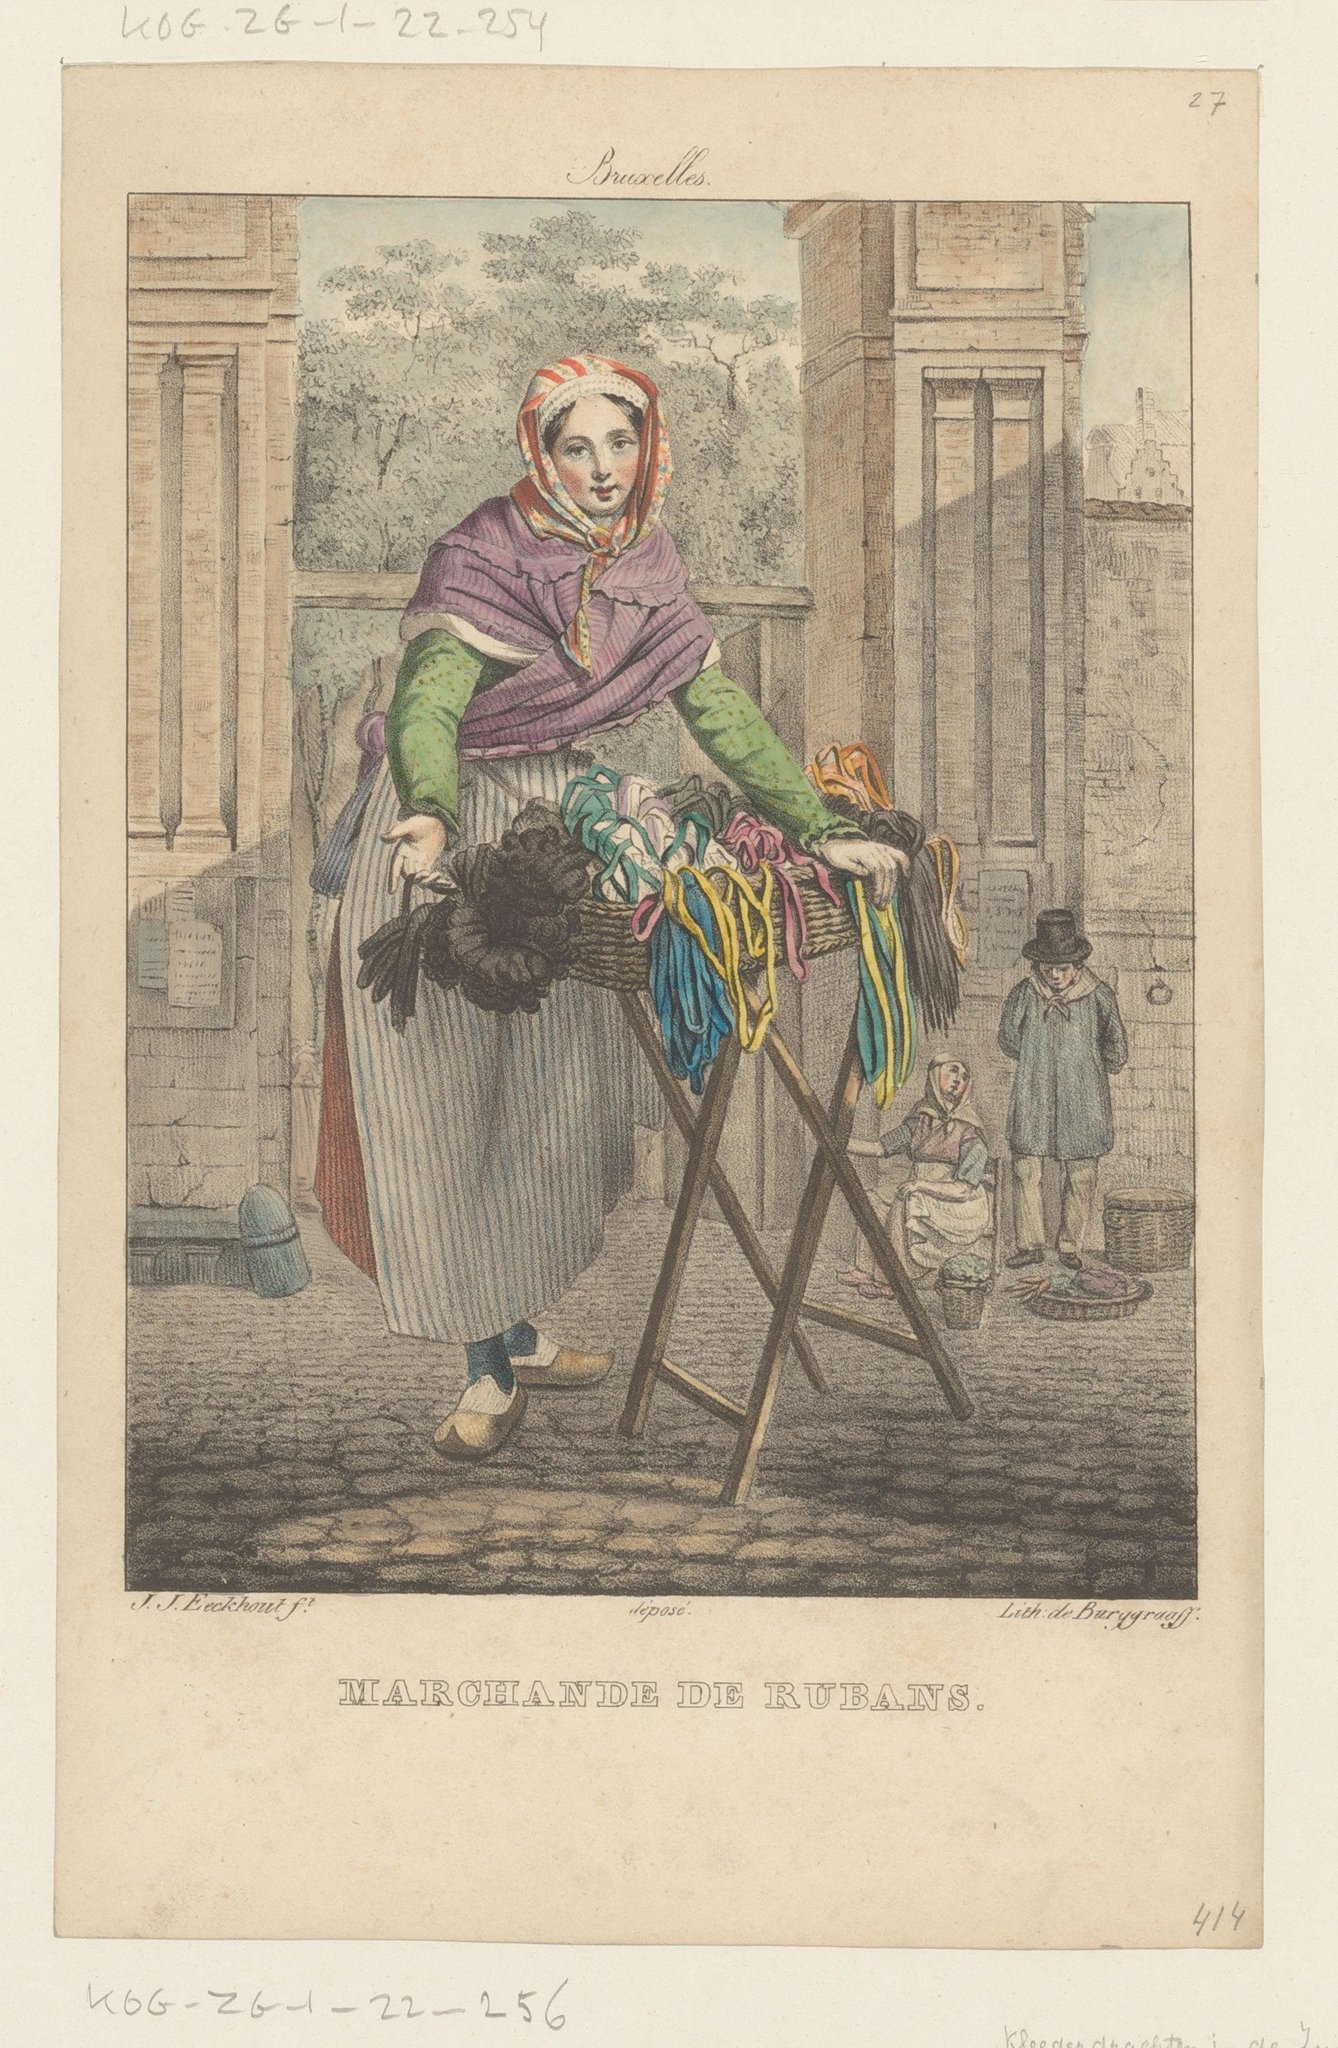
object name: print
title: Verkoopster van linten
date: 1835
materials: paper, watercolor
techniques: hand coloring, lithograph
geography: brussels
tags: street-trader - bb - women engaged in trade and commerce, clothes, costume (+ women's clothes), bow (ornamental part of clothing), folk costume, regional costume, southern netherlands, brussels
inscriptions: collector's mark: Lugt 1641, collector's mark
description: Van den Burggraaff wilde een serie (twintig afleveringen met telkens vier platen) uitgeven met kostuums uit alle provincies van Nederland en België onder de titel 'Costumes du peuple de toutes les provinces des Pays-Bas'. Hij begint met deze serie in 1825 en eindigt hiermee bij de dertiende aflevering in 1830. Omdat in 1830 België zich afsplitst van Nederland geeft hij de prenten daarna apart uit onder de titels 'Costumes de peuple Hollandais' en 'Collection de costumes du peuple des provinces de la Belgique' (1835).